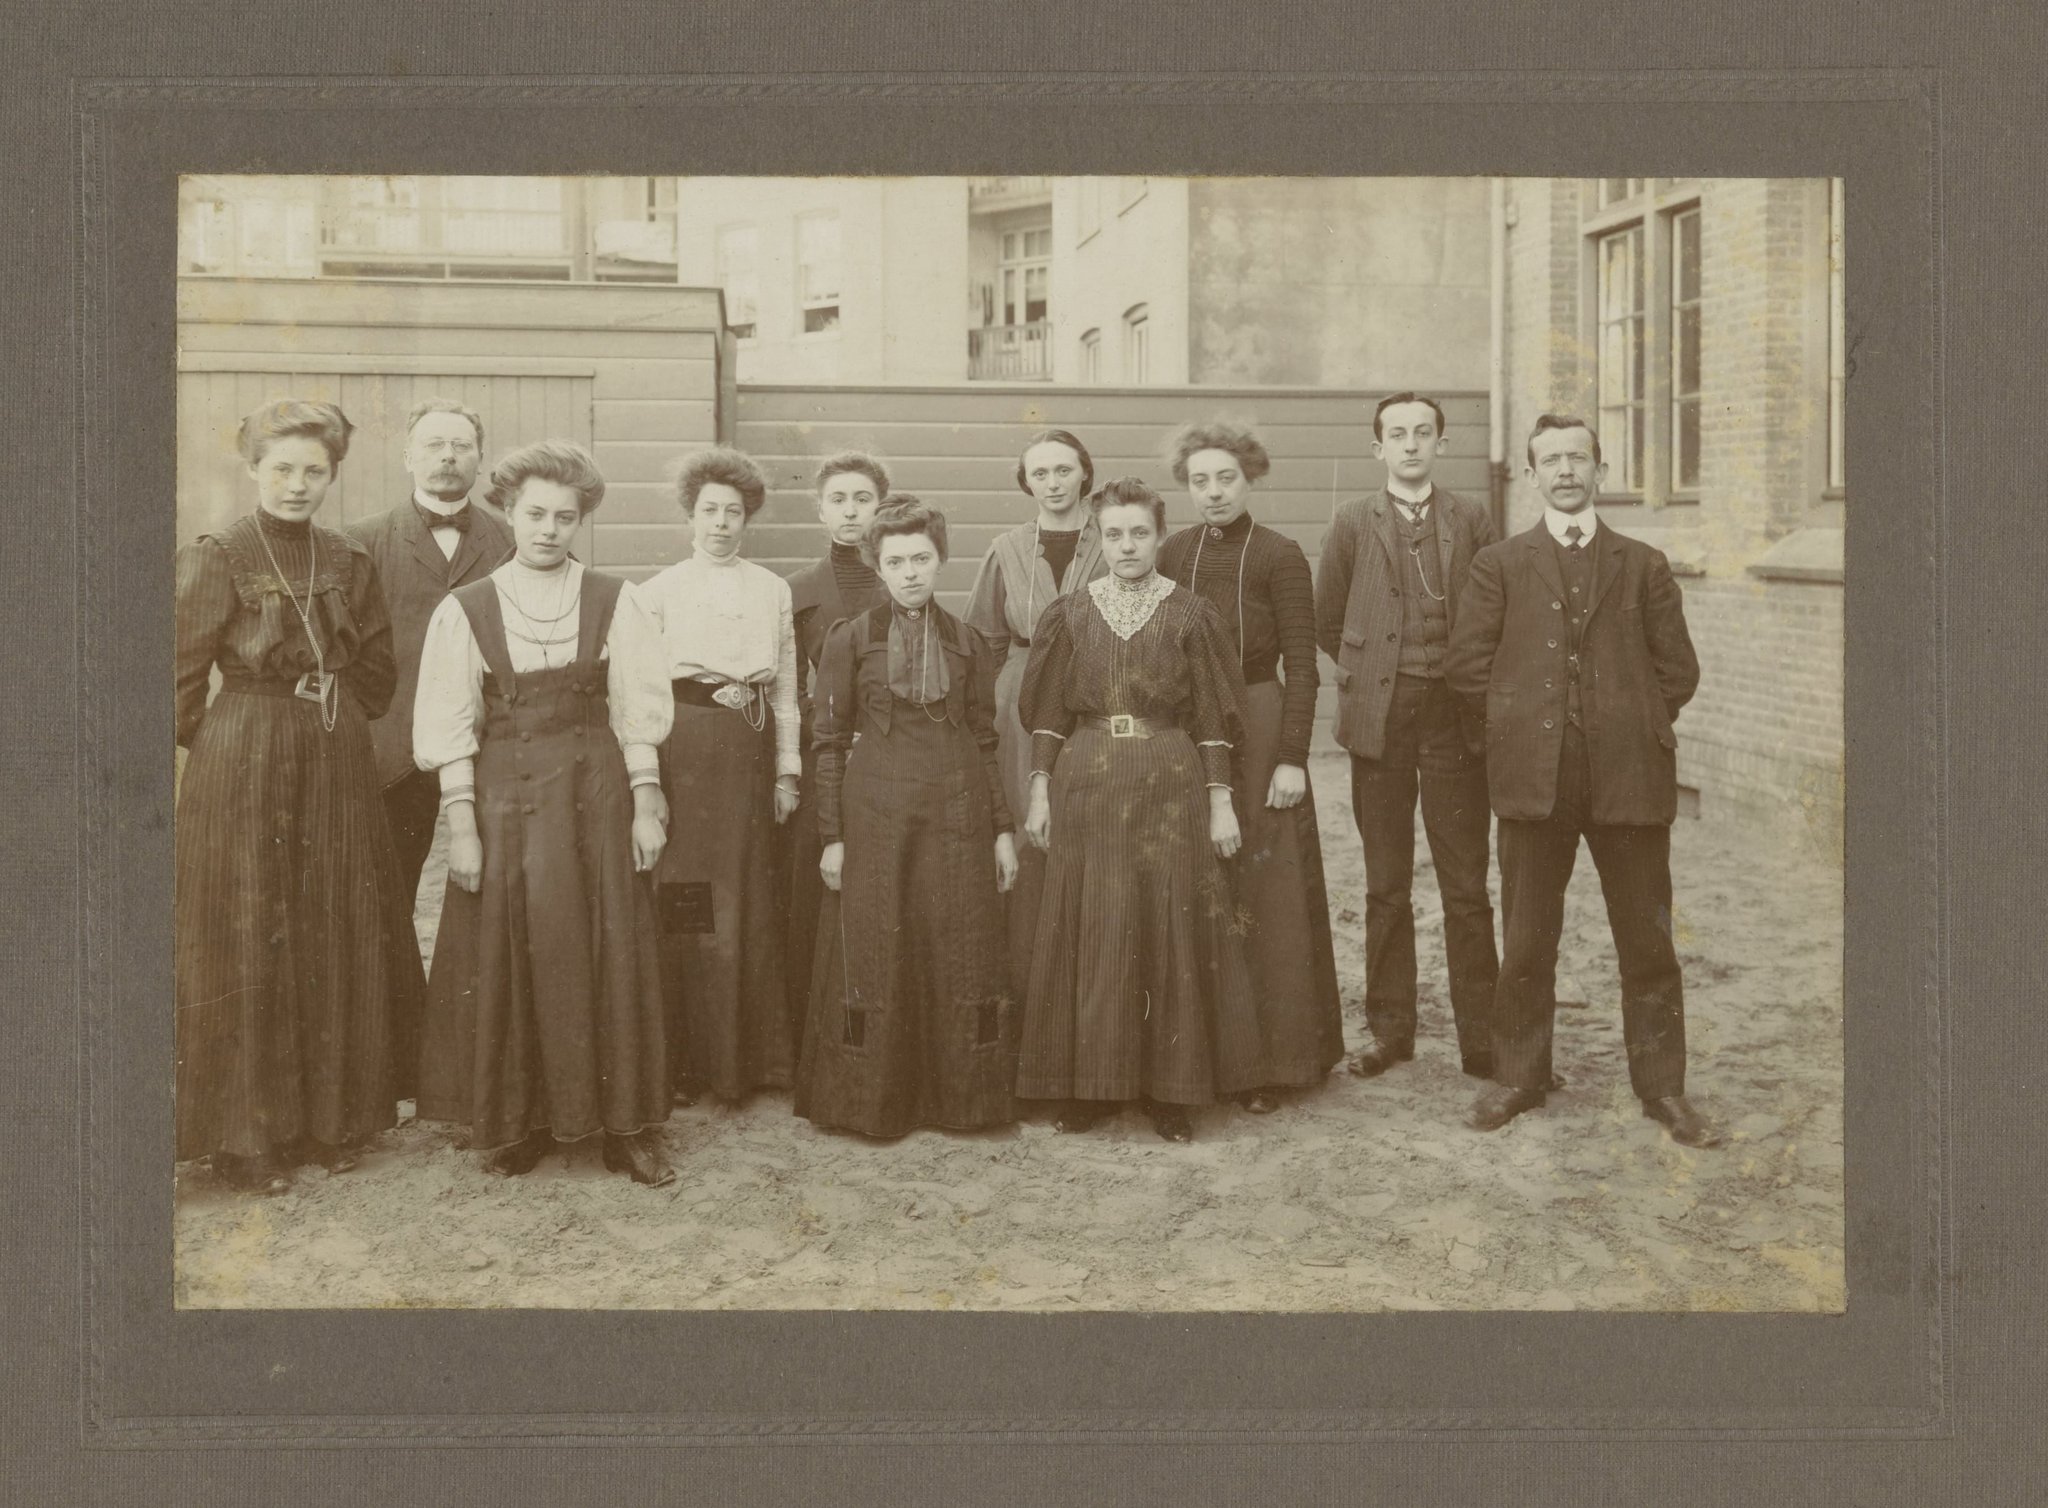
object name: photograph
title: Schoolfoto van klas met grotere meisjes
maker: Anonymous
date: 1905-1915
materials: cardboard, photographic support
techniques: gelatin silver print